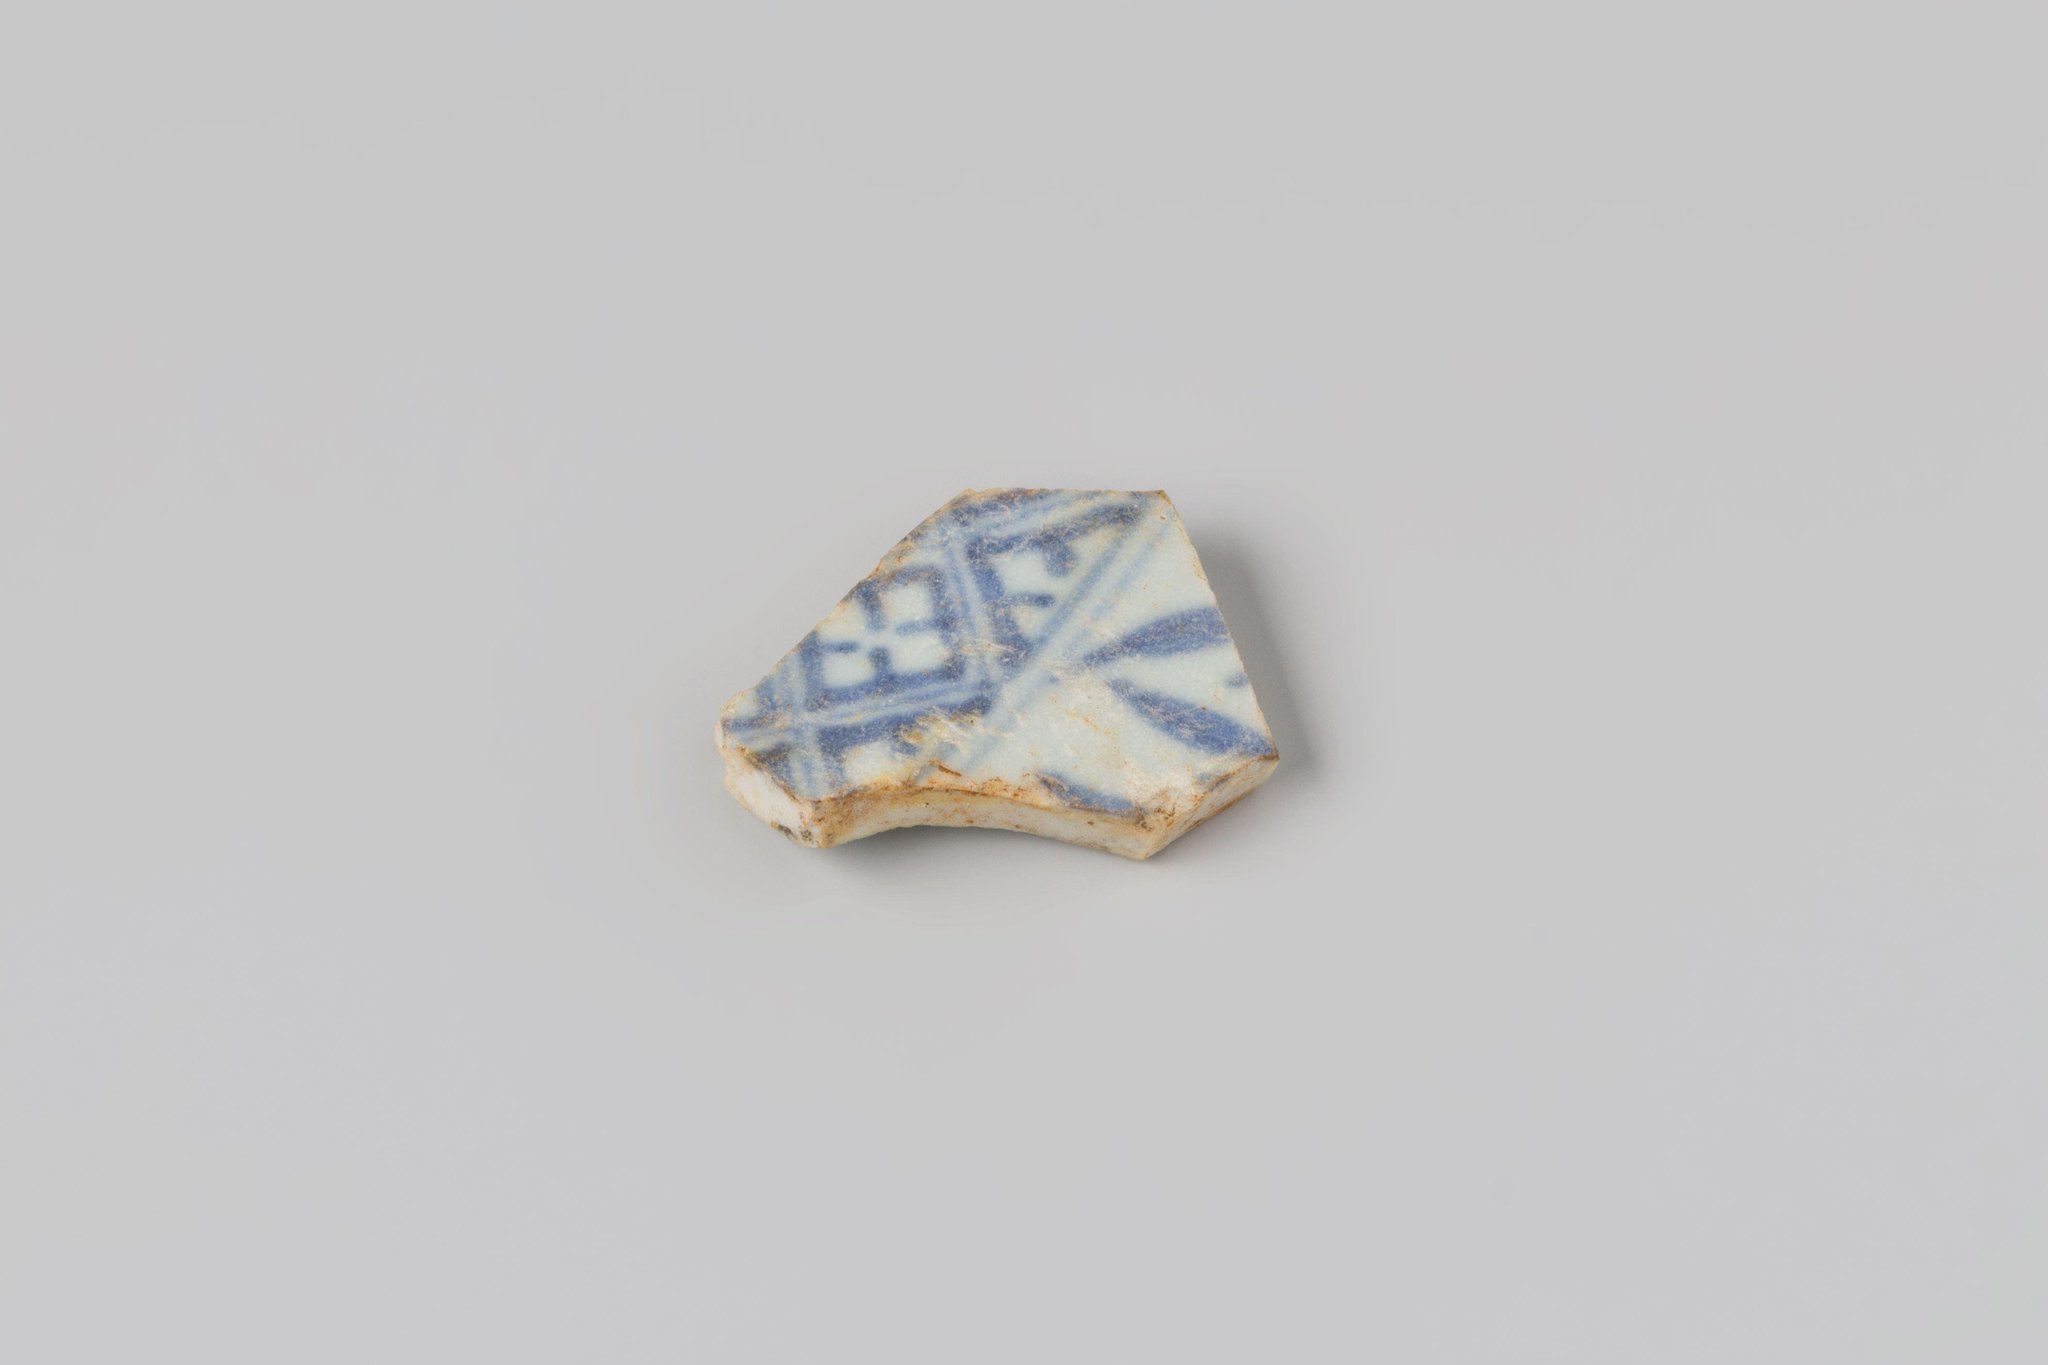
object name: sherd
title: Scherf van een bord uit het wrak van de Oost-Indiëvaarder Hollandia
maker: Anonymous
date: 1700-1743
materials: porcelain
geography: netherlands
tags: verenigde oostindische compagnie, hollandia (schip), annet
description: Porcelain, plate, type 2; fragm of rim, sim. NG 1980-27H2624h.